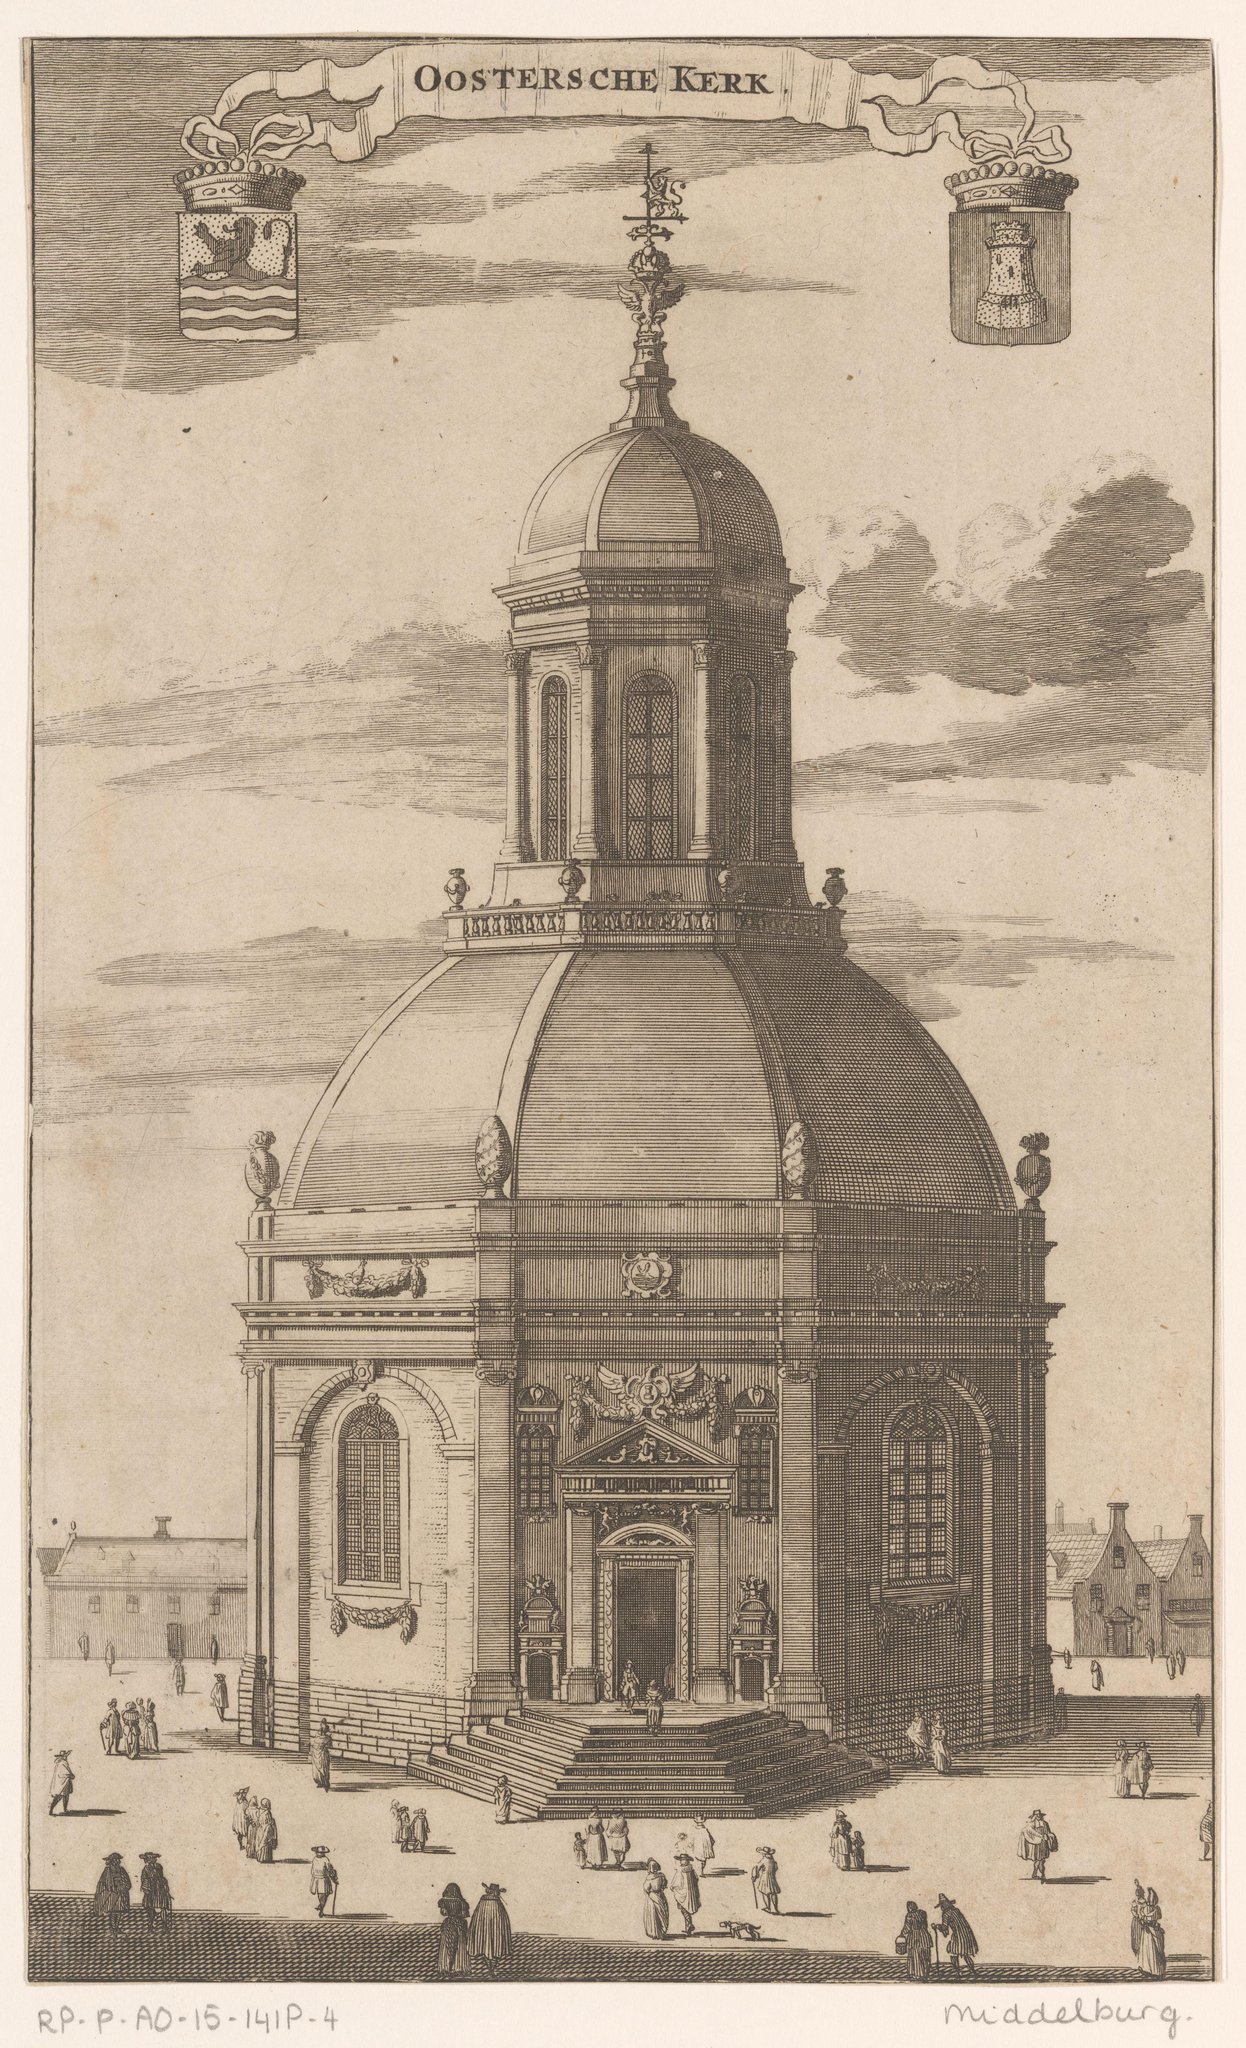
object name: book illustration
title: Oostersche Kerk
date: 1696-1728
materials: paper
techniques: engraving, etching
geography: middelburg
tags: coat of arms (as symbol of the state, etc.) (+ city; municipal), church (exterior), coat of arms (as symbol of the state, etc.) (+ province; provincial)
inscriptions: collector's mark: Lugt 195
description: Oorspronkelijk van één plaat gedrukt met één andere voorstelling (zie RP-P-AO-15-141P-3). Prent in zijn geheel ook gebruikt in: Smallegange, Mattheus. Nieuwe Cronyk van Zeeland (…). Middelburg en Amsterdam: Johannes Meertens en Abraham van Someren, 1696. En huidige voorstelling los (plaat mogelijk versneden) ook gebruikt in: Aa, Pieter van der. La galerie agreable du monde (...). 66 delen. Leiden: Pieter van der Aa, 1728, dl. 20.